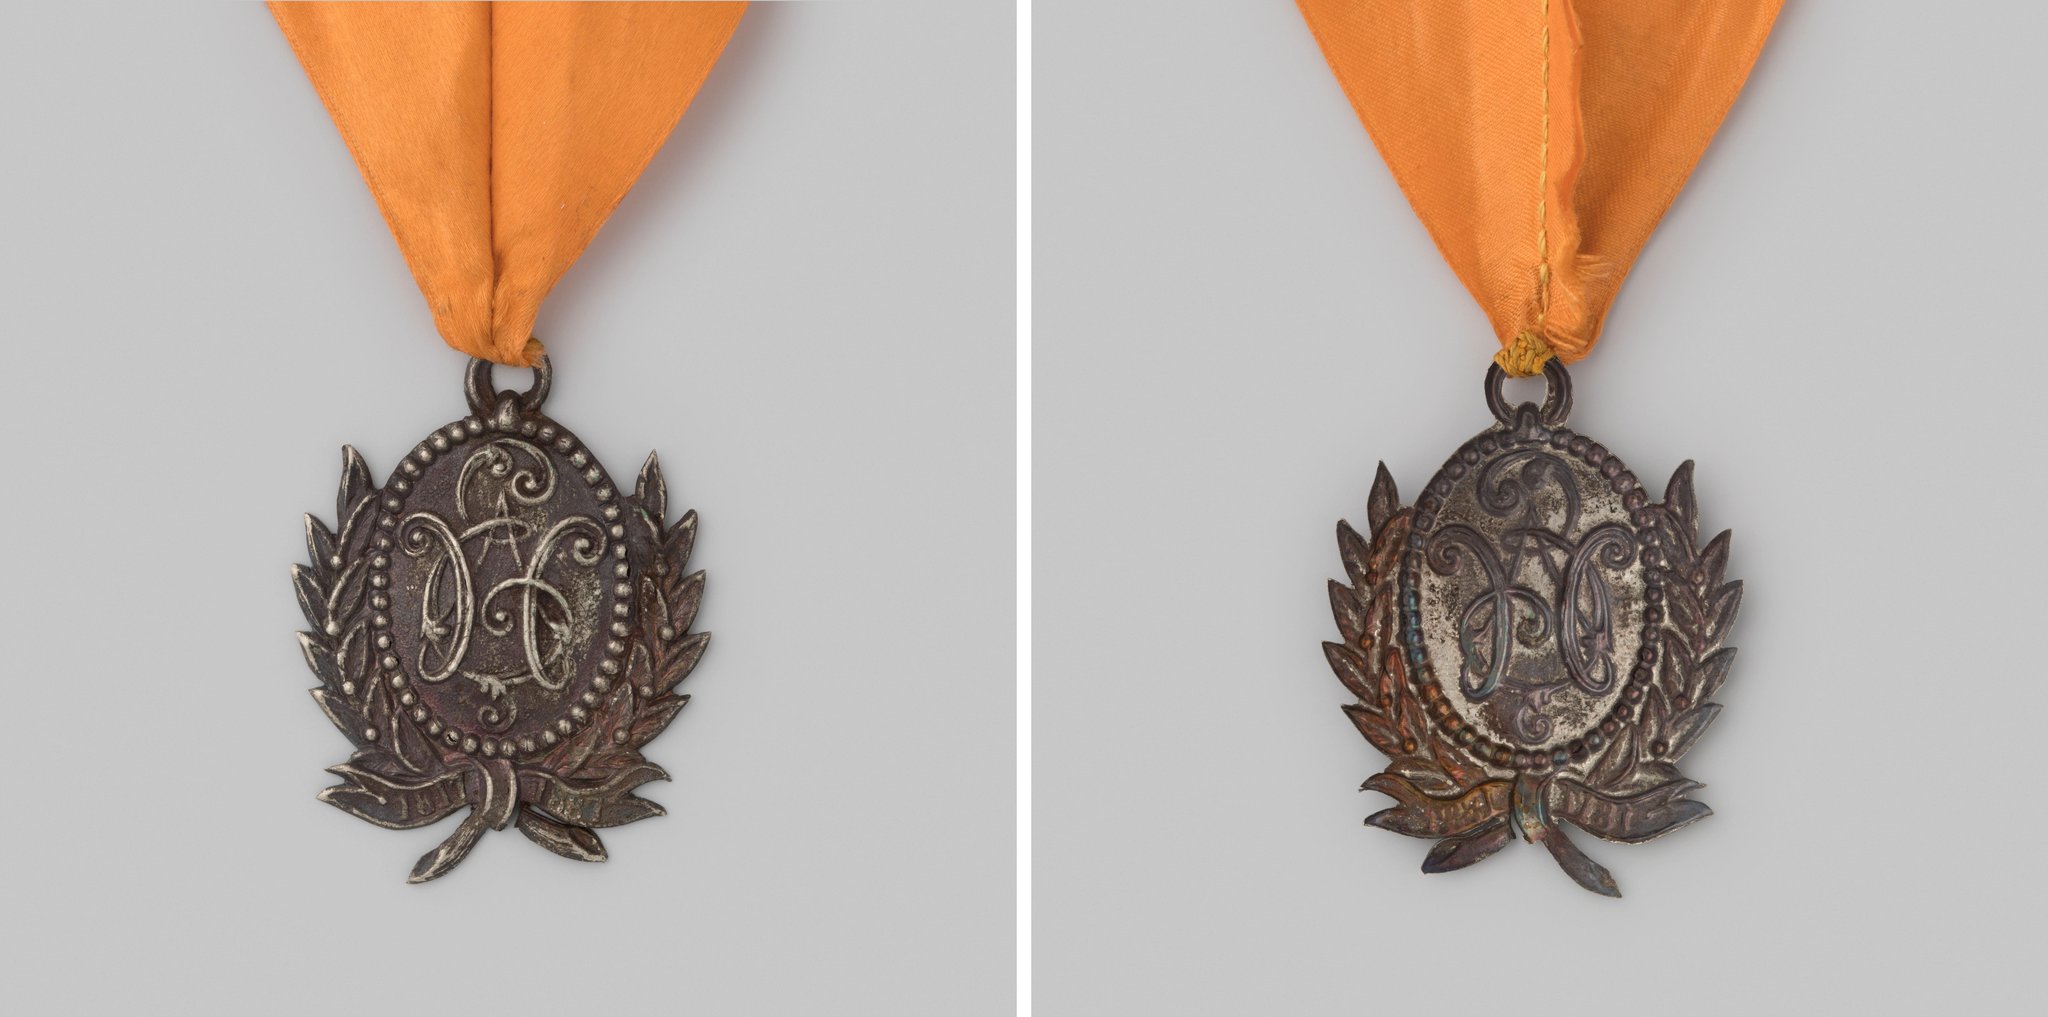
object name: insignia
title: Zeventigste verjaardag van Koning Willem III 1887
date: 1887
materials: silver, textile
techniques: pressing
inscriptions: inscription: ‘1817 - 1887’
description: Eenzijdig zilveren draagteken met oog aan een oranje halslint, WE-monogram op een ovaal veld met parelrand, tussen lauwertakken samengebonden met een tekstlint.